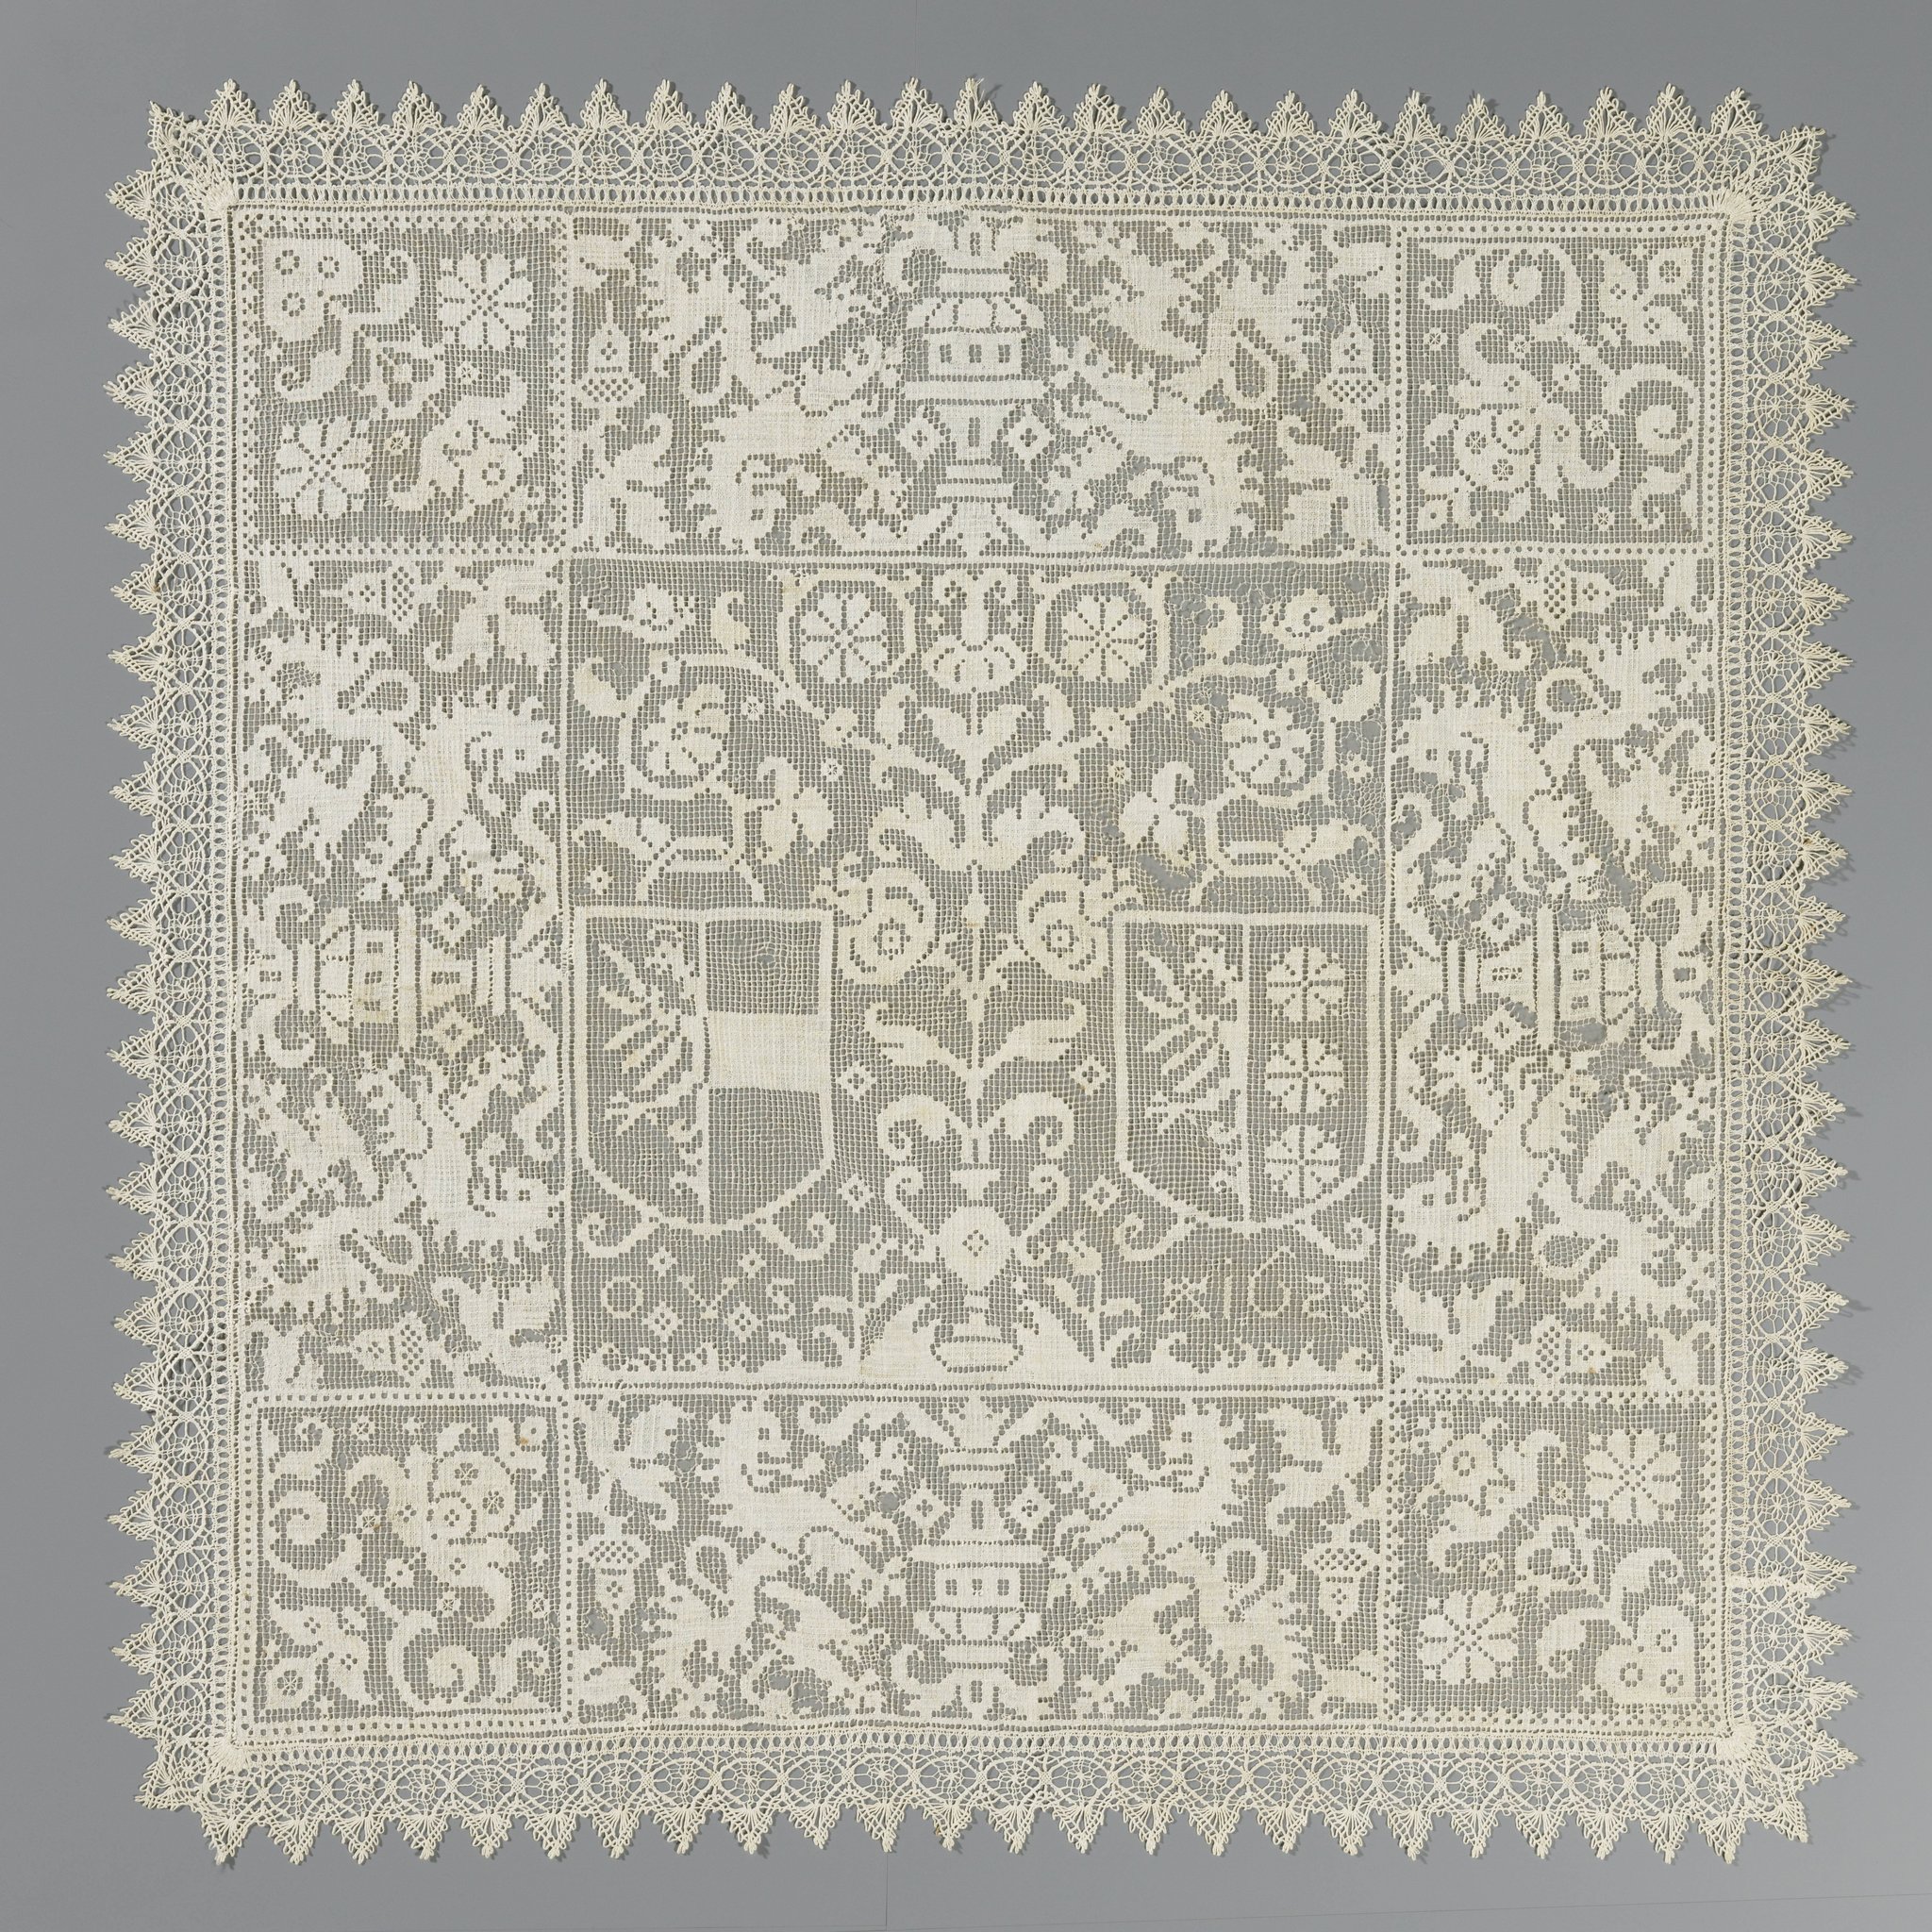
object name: kleed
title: Kleed van linnen in filetwerk en met kloskant, met voorstelling van de wapens Sickinge en Jongema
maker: oedt van sickinge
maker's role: artisan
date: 1623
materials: linen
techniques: lace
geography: groningen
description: Kleed van linnen in filetwerk met een rand van kloskant, met voorstelling van de wapens Sickinge en Jongema. Initialen OVS wellicht van Groningse Oedt van Sickinge, die in dat geval het kleed voor haar ouders zou hebben gemaakt. Gedateerd 1623.